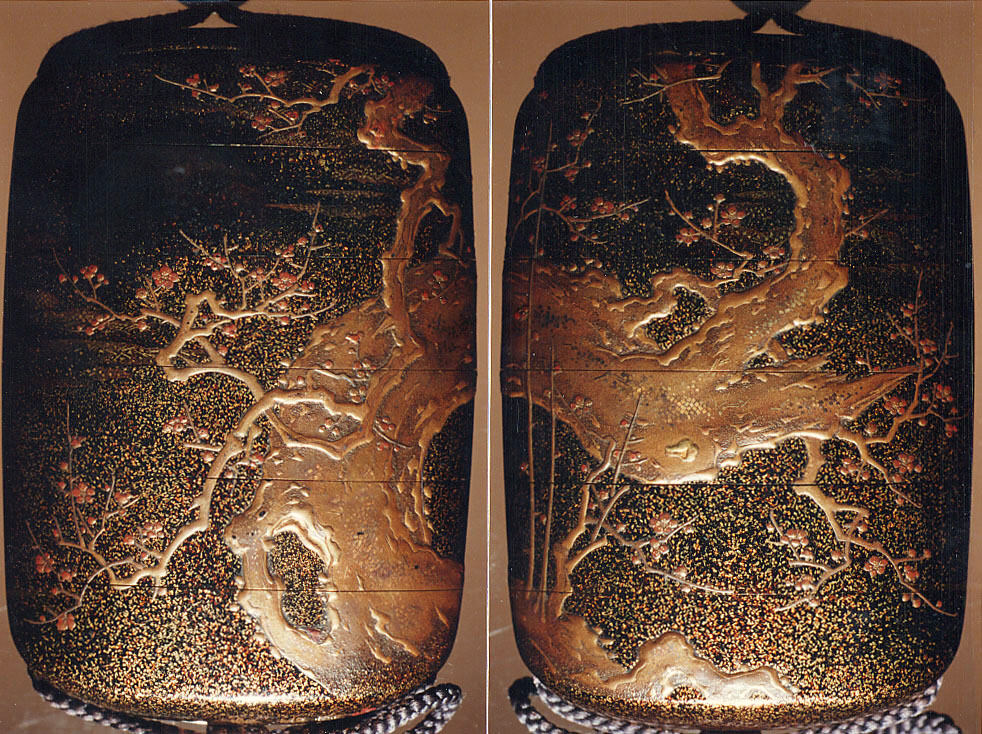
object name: inrō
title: Case (Inrō) with Design of Blossoming Plum Tree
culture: japanese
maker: kano seisen’in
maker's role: artist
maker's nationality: japanese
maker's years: 1775-1828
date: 1801-1900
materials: gold, lacquer, silver, shell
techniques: maki, maki-e, weave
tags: trees